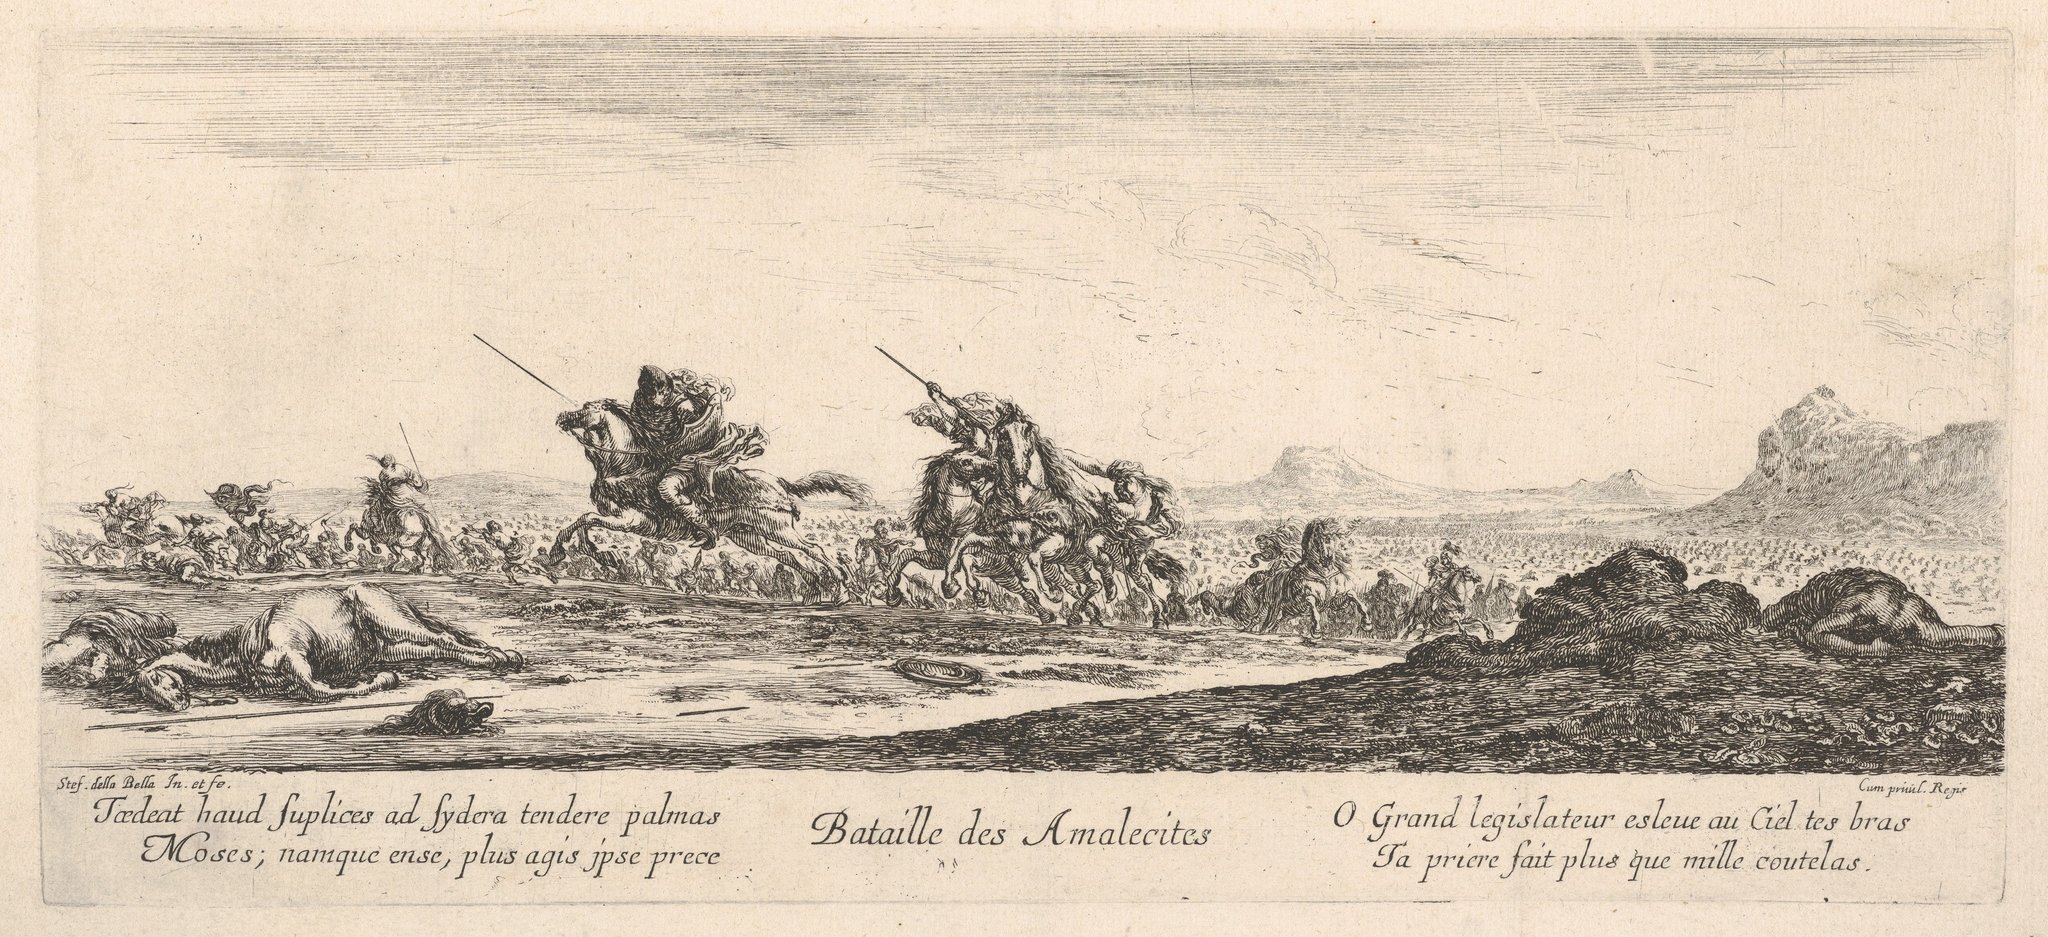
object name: print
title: Battle of the Amalekites (Bataille des Amalecites)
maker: stefano della bella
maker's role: artist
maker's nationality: italian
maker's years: 1610-1664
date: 1645-1652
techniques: etching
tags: battles,men,horses,landscapes,death